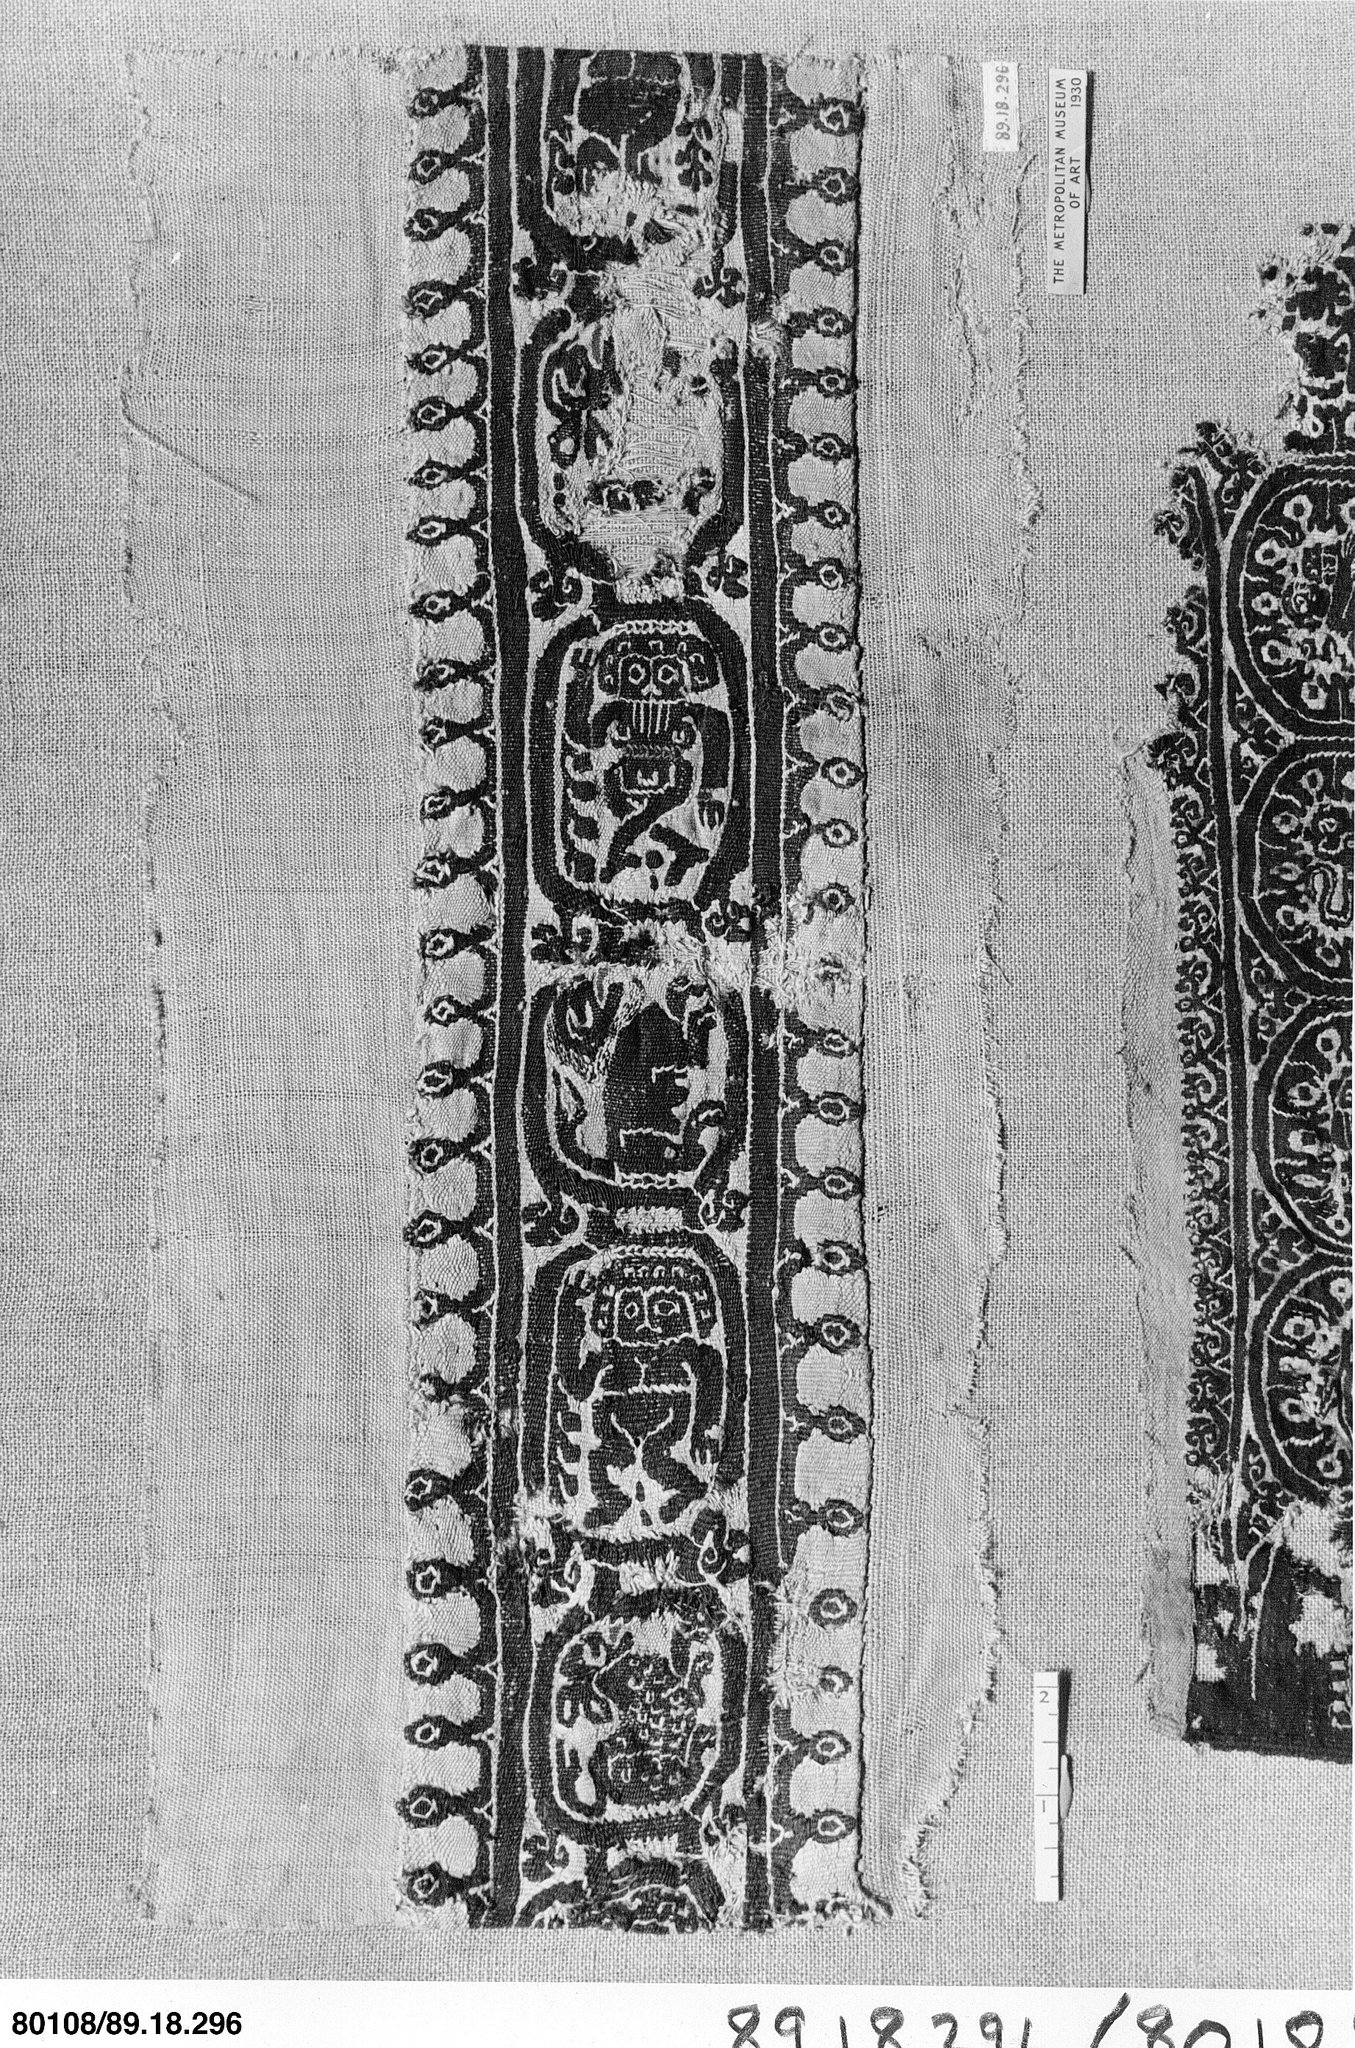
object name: textile fragment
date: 301-400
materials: linen, wool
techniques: weave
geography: egypt